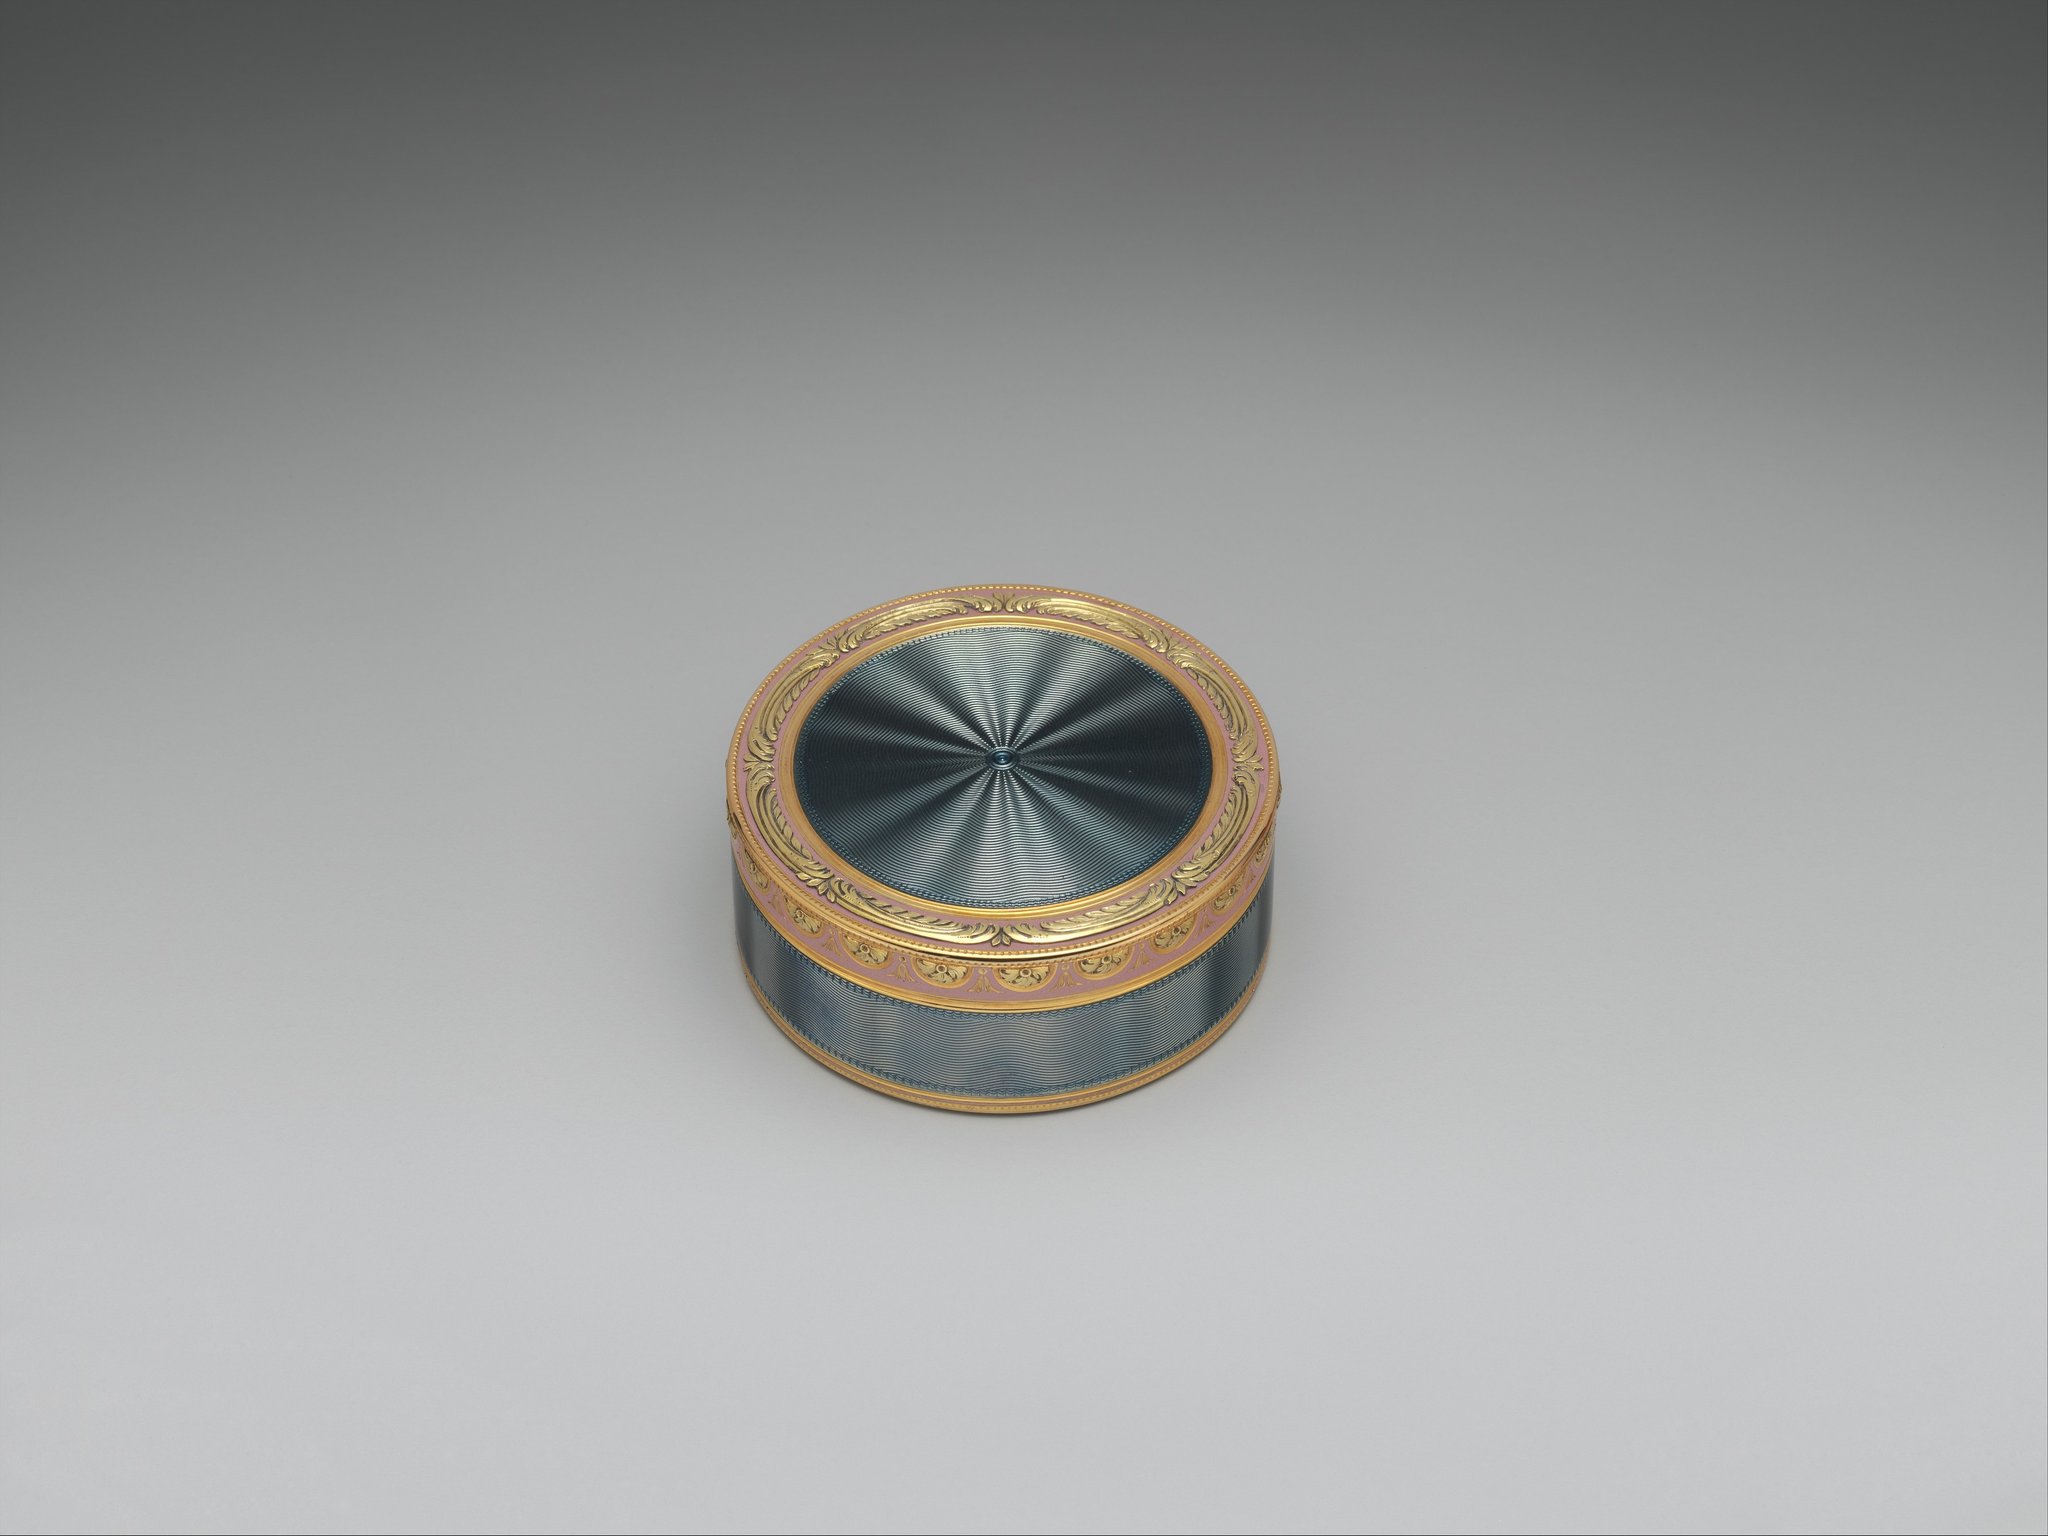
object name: snuffbox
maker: charles le bastier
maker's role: maker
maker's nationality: french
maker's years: 1724-1783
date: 1773-1774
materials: enamel, gold